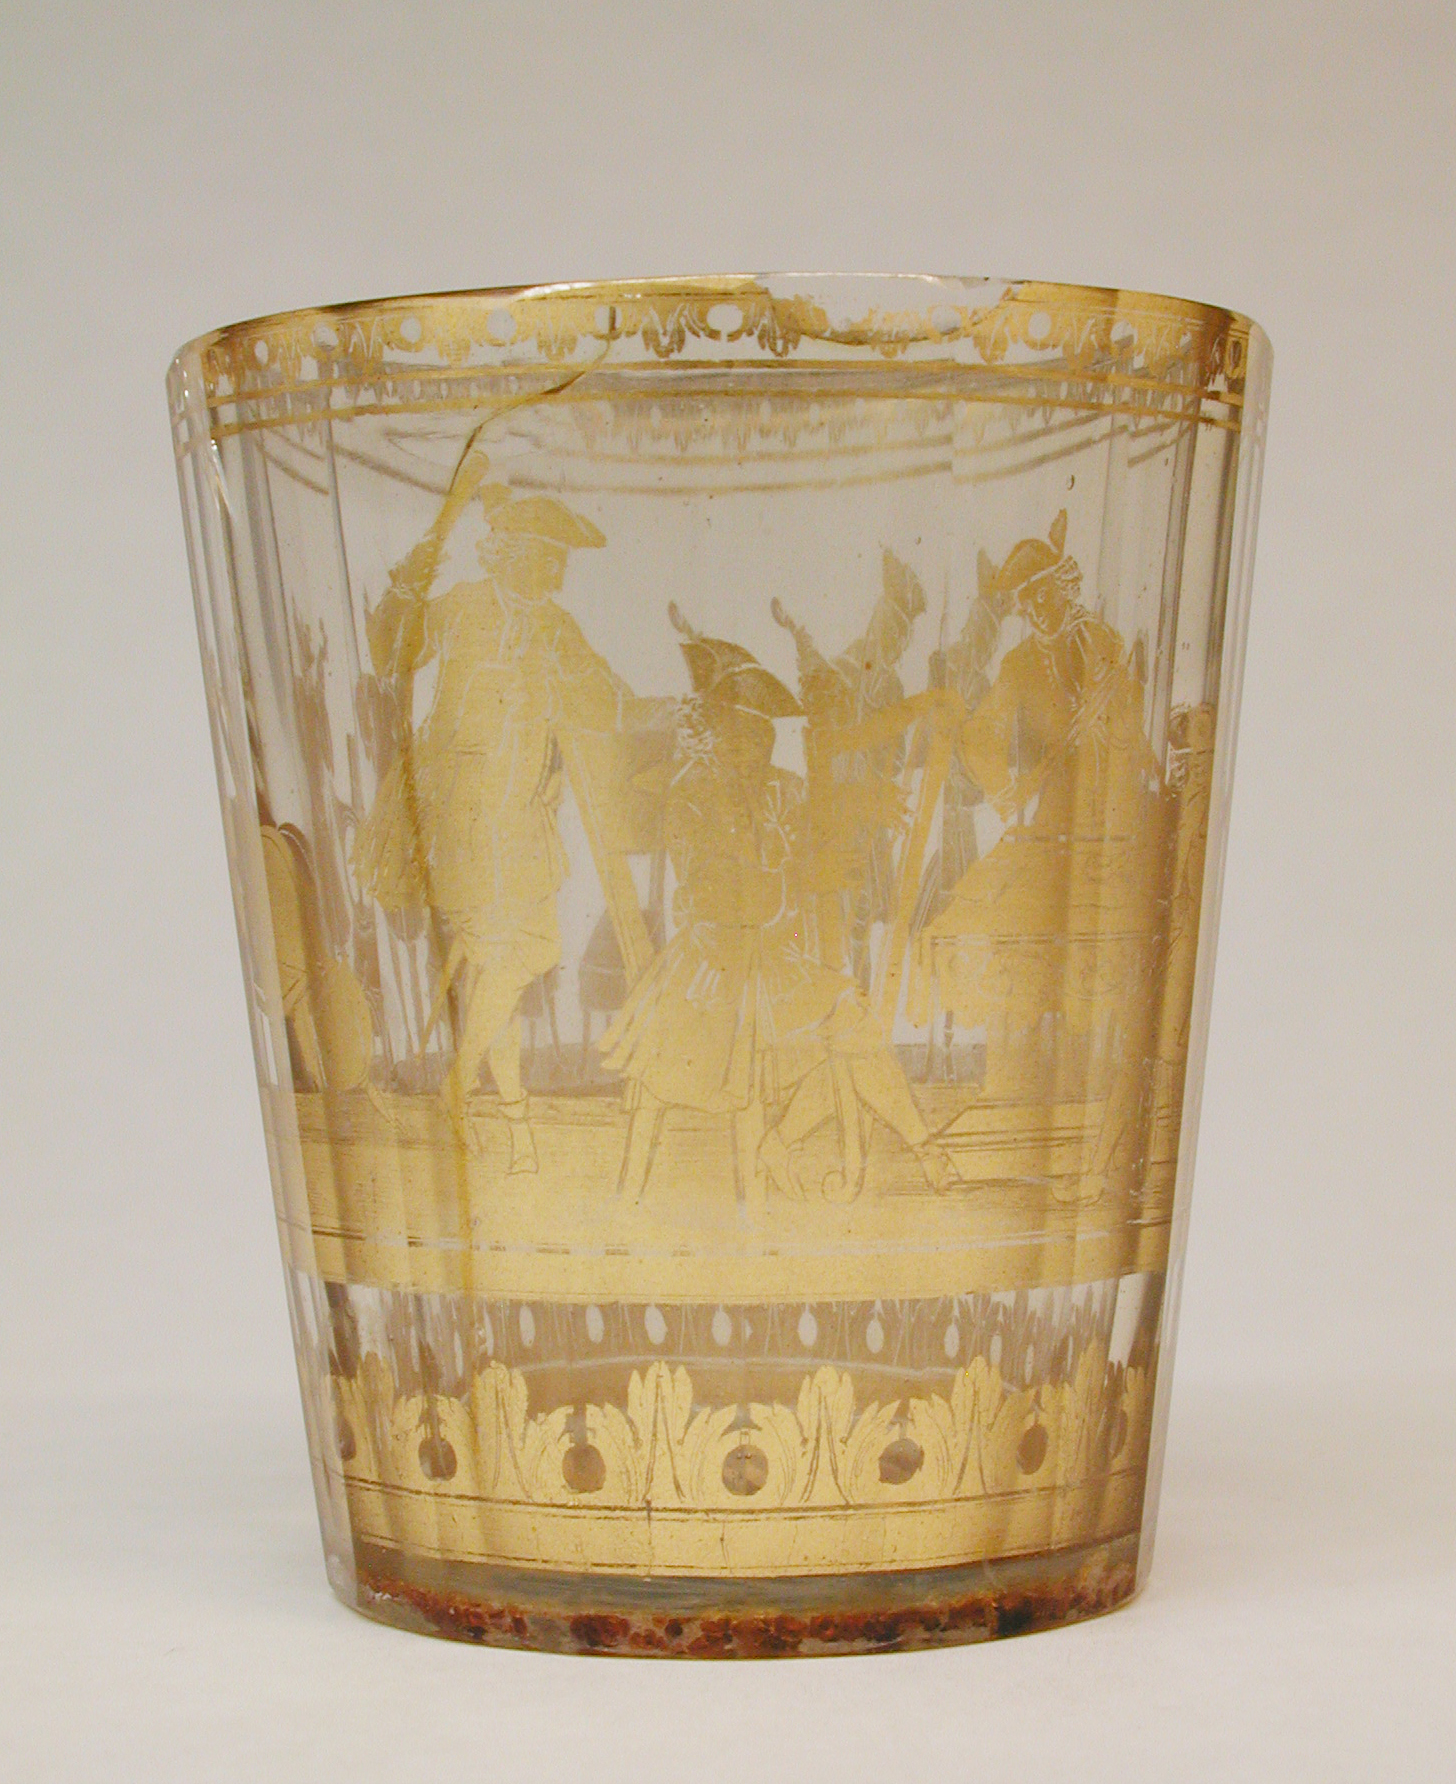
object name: beaker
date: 1730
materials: glass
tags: men,harps